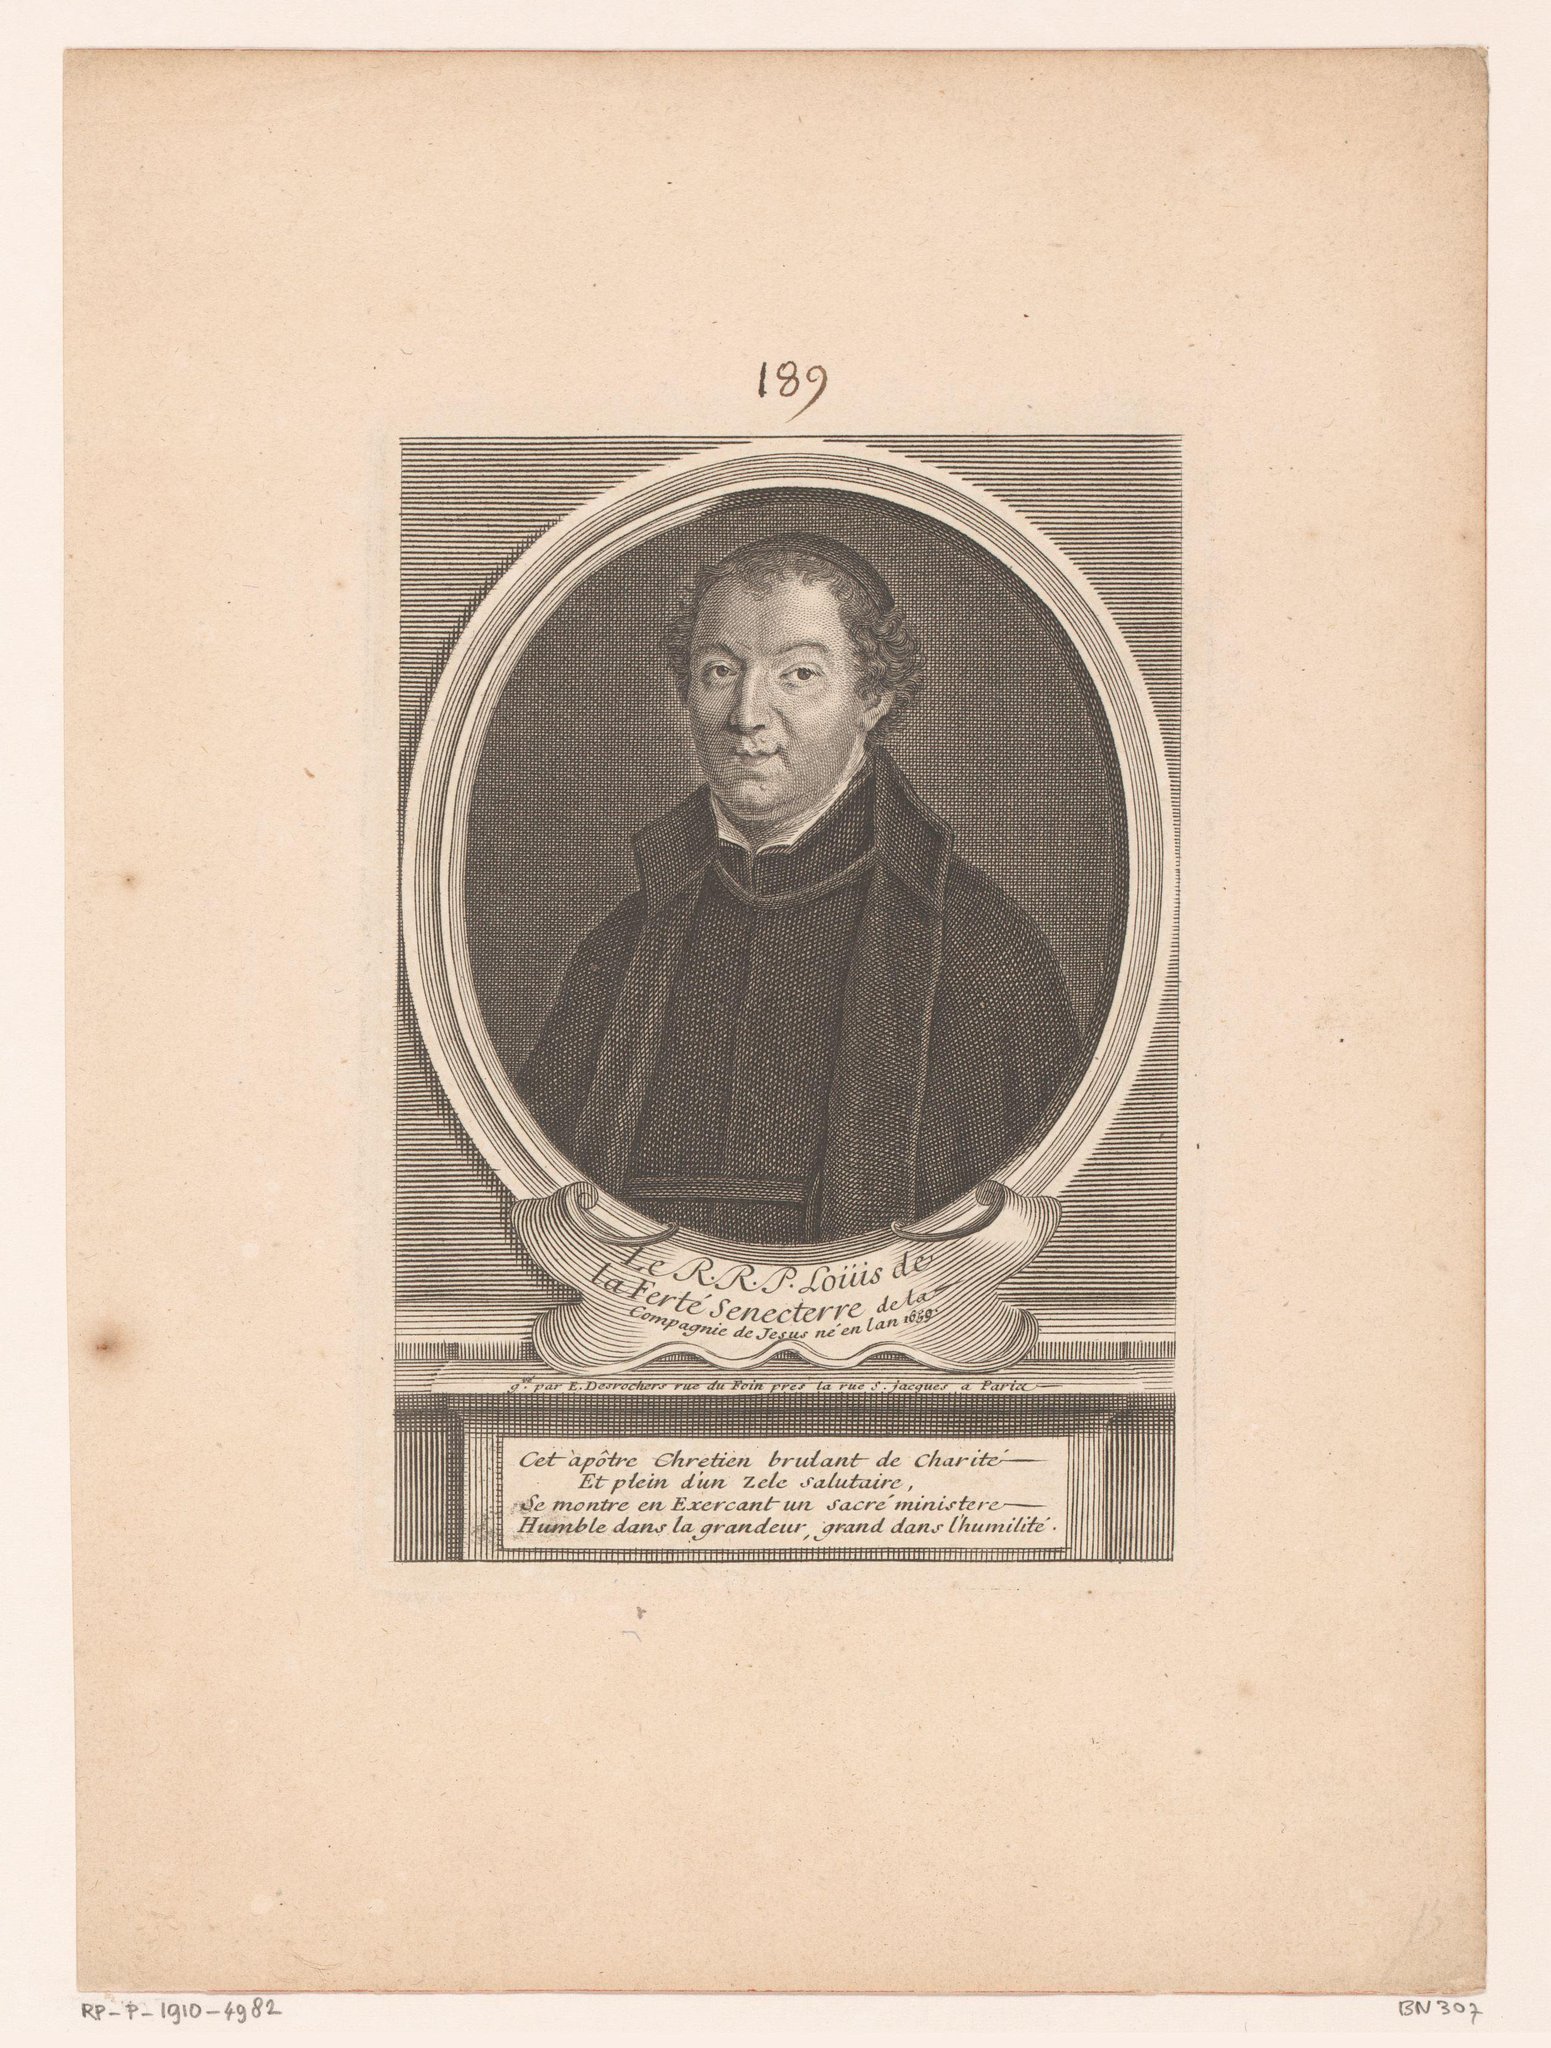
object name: print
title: Recueil de portraits (...)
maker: étienne desrochers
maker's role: print maker, publisher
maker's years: 1668-1741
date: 1726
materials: paper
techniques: engraving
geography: paris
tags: historical persons, regular clerics, e.g. jesuits, redemptorists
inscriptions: collector's mark: Lugt 2228, number: ‘189’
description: Behoort waarschijnlijk tot een serie portretten, grotendeels door Etienne Desrochers, getiteld: 'Recueil de portraits de personnes qui se sont distinguées tant dans les Armes que dans Belles-Lettres et les Arts, comme aussi la famille royale de France et autres cours étrangères'. De serie werd initieel uitgegeven door Desrochers en aangekondigd in 'Mercure' in mei 1726, p. 985. Echter was Desrochers reeds enkele jaren eerder begonnen met het uitgeven van de serie. Na de dood van Desrochers werd de serie voortgezet door Gilles Edme Petit. Een latere staat werd uitgegeven door Jean François Daumont in Parijs.